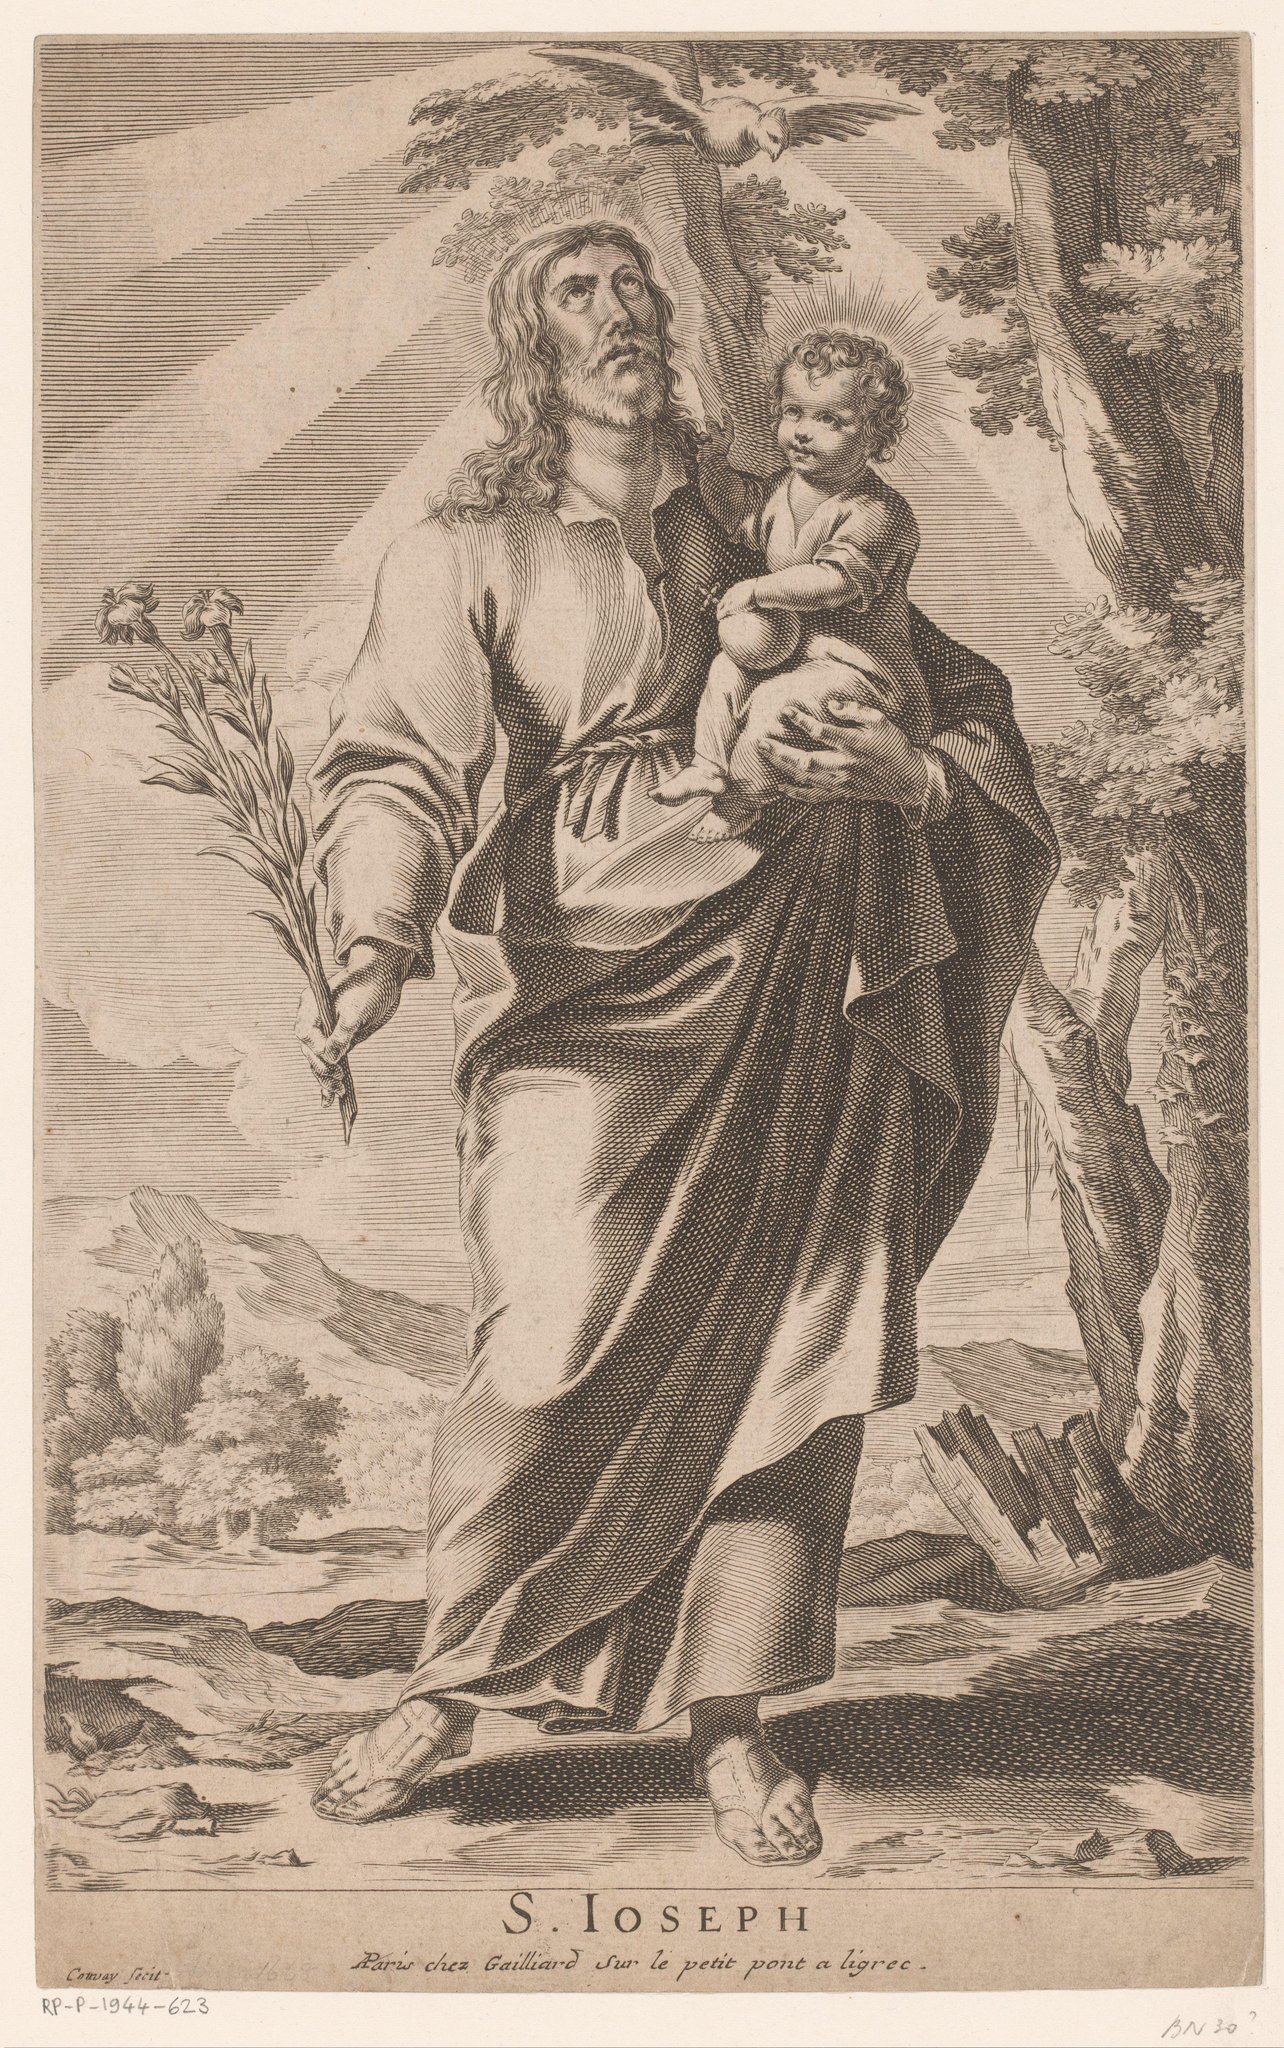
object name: print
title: Heilige Jozef met Christuskind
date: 1632-1675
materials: paper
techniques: engraving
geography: paris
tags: joseph and the christ-child ~ daily life in nazareth, the foster-father of christ, joseph of nazareth, husband of mary; possible attributes: flowering rod or wand, lily, carpenter's tools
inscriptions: collector's mark: Lugt 2228